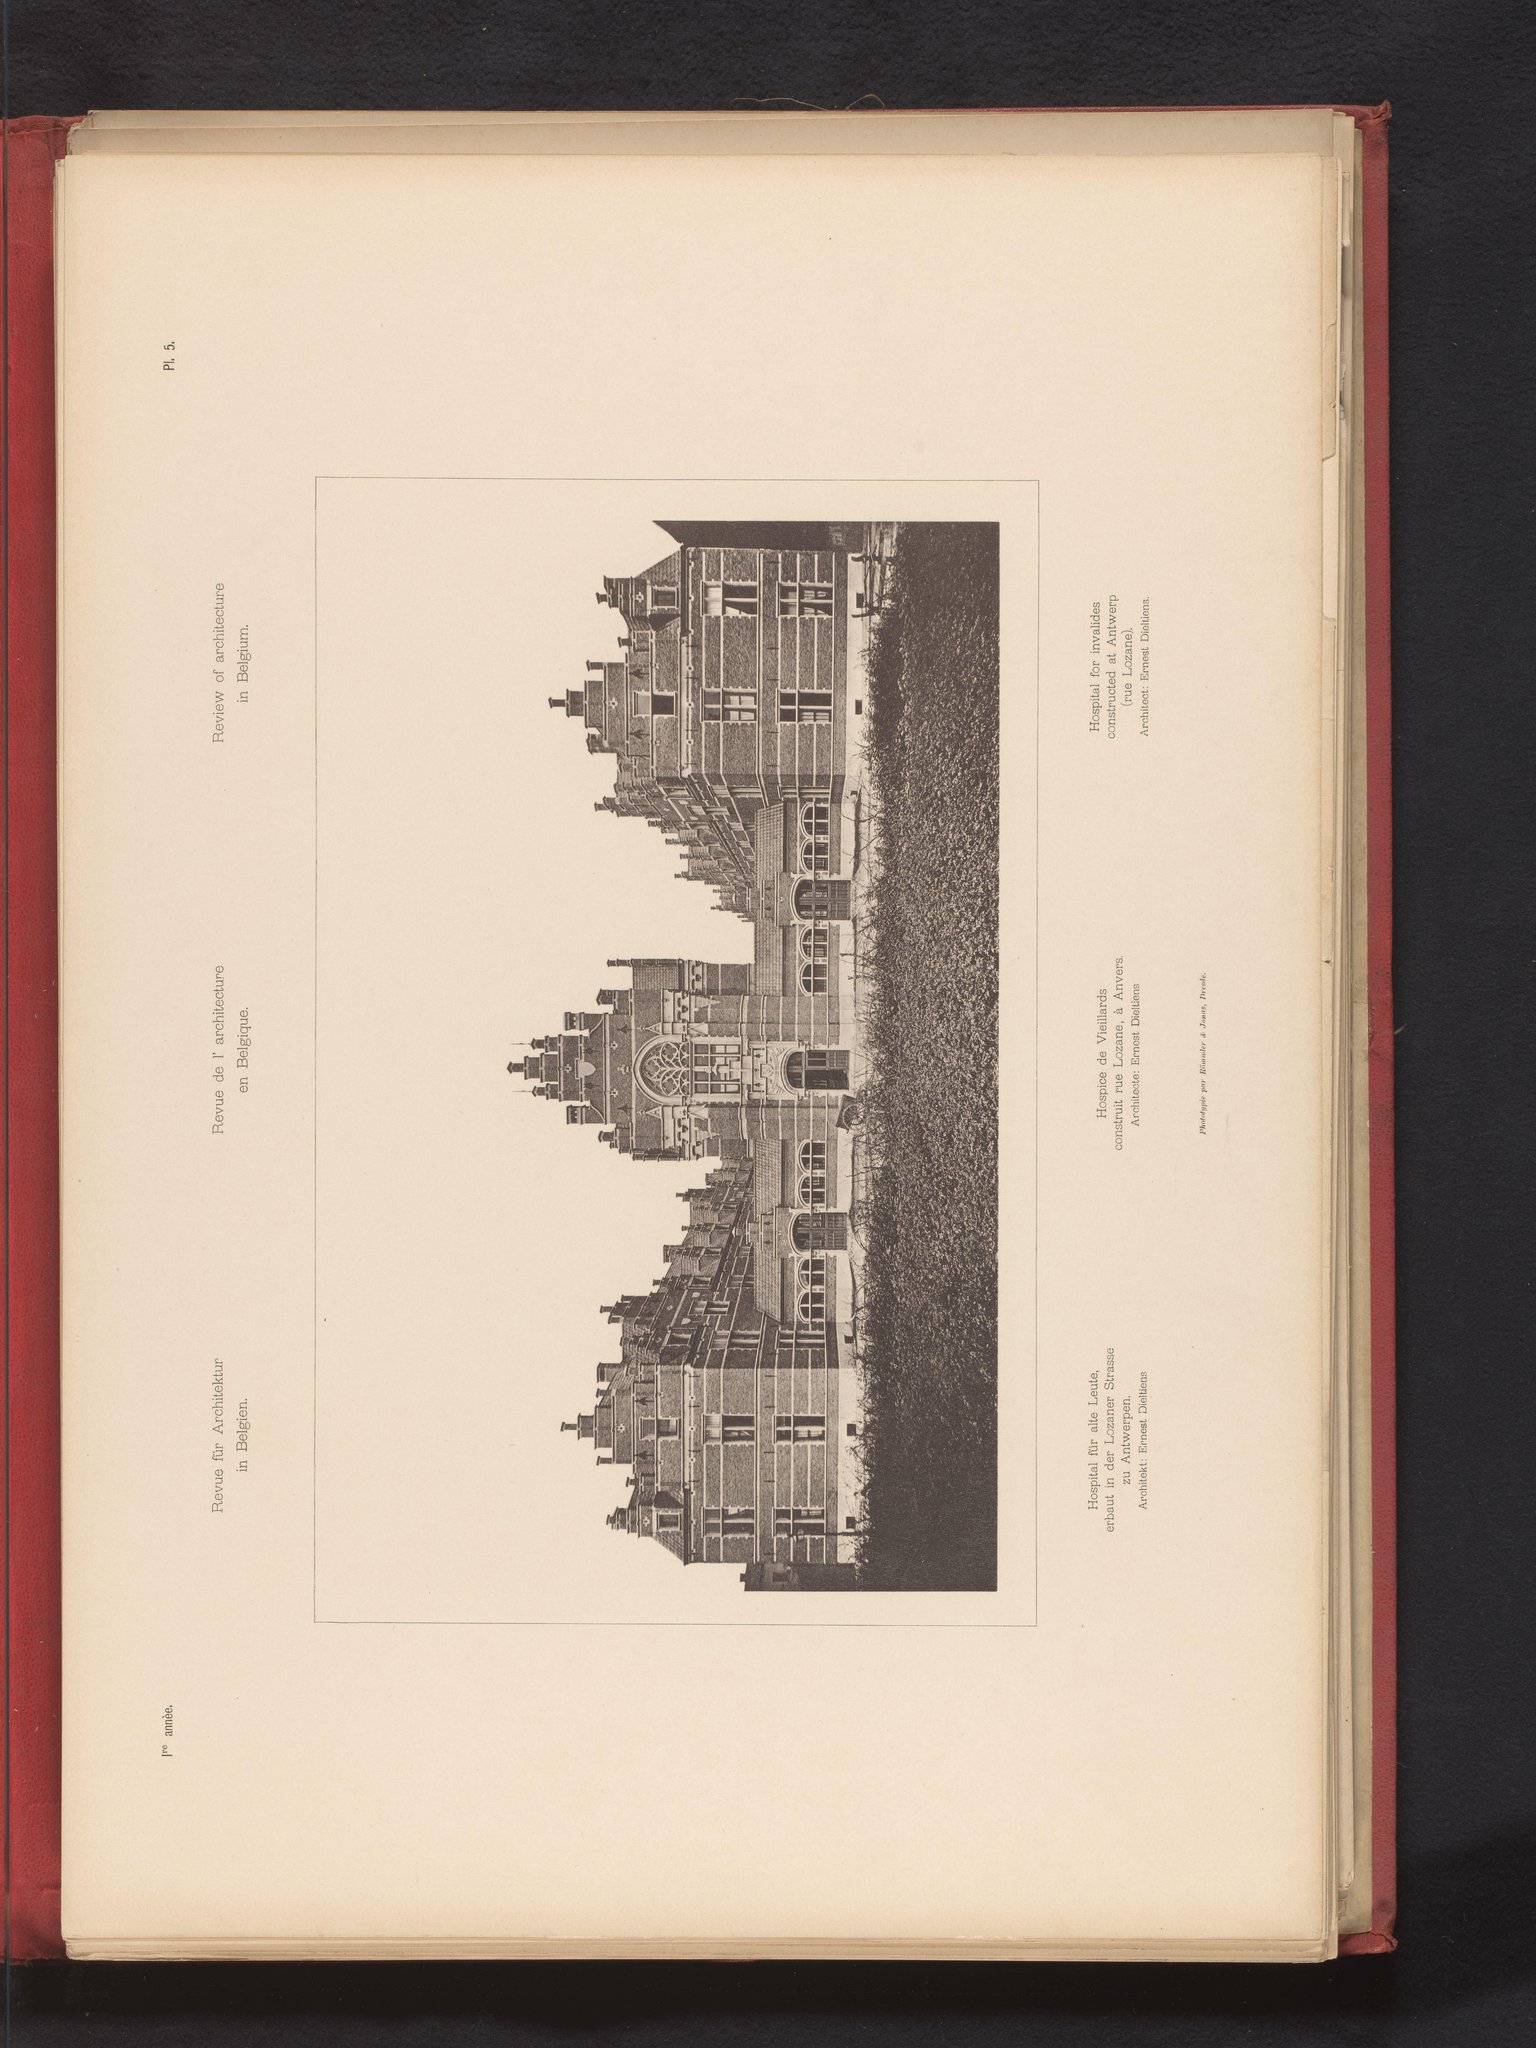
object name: photomechanical print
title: Hospice de Vieillards construit rue Lozane, à Anvers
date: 1888-1893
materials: paper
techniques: photograph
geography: dresden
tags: hospital, antwerp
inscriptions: number: ‘Pl. 5.’, inscription: ‘Architect: Ernest Dieltiens’, inscription: ‘Architecte: Ernest Dieltiens’, inscription: ‘1re. annèe.’, inscription: ‘Architekt: Ernest Dieltiens’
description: Deze prent maakt deel uit van een omslag met 110 prenten op 90 bladen en 18 tekstbladen.